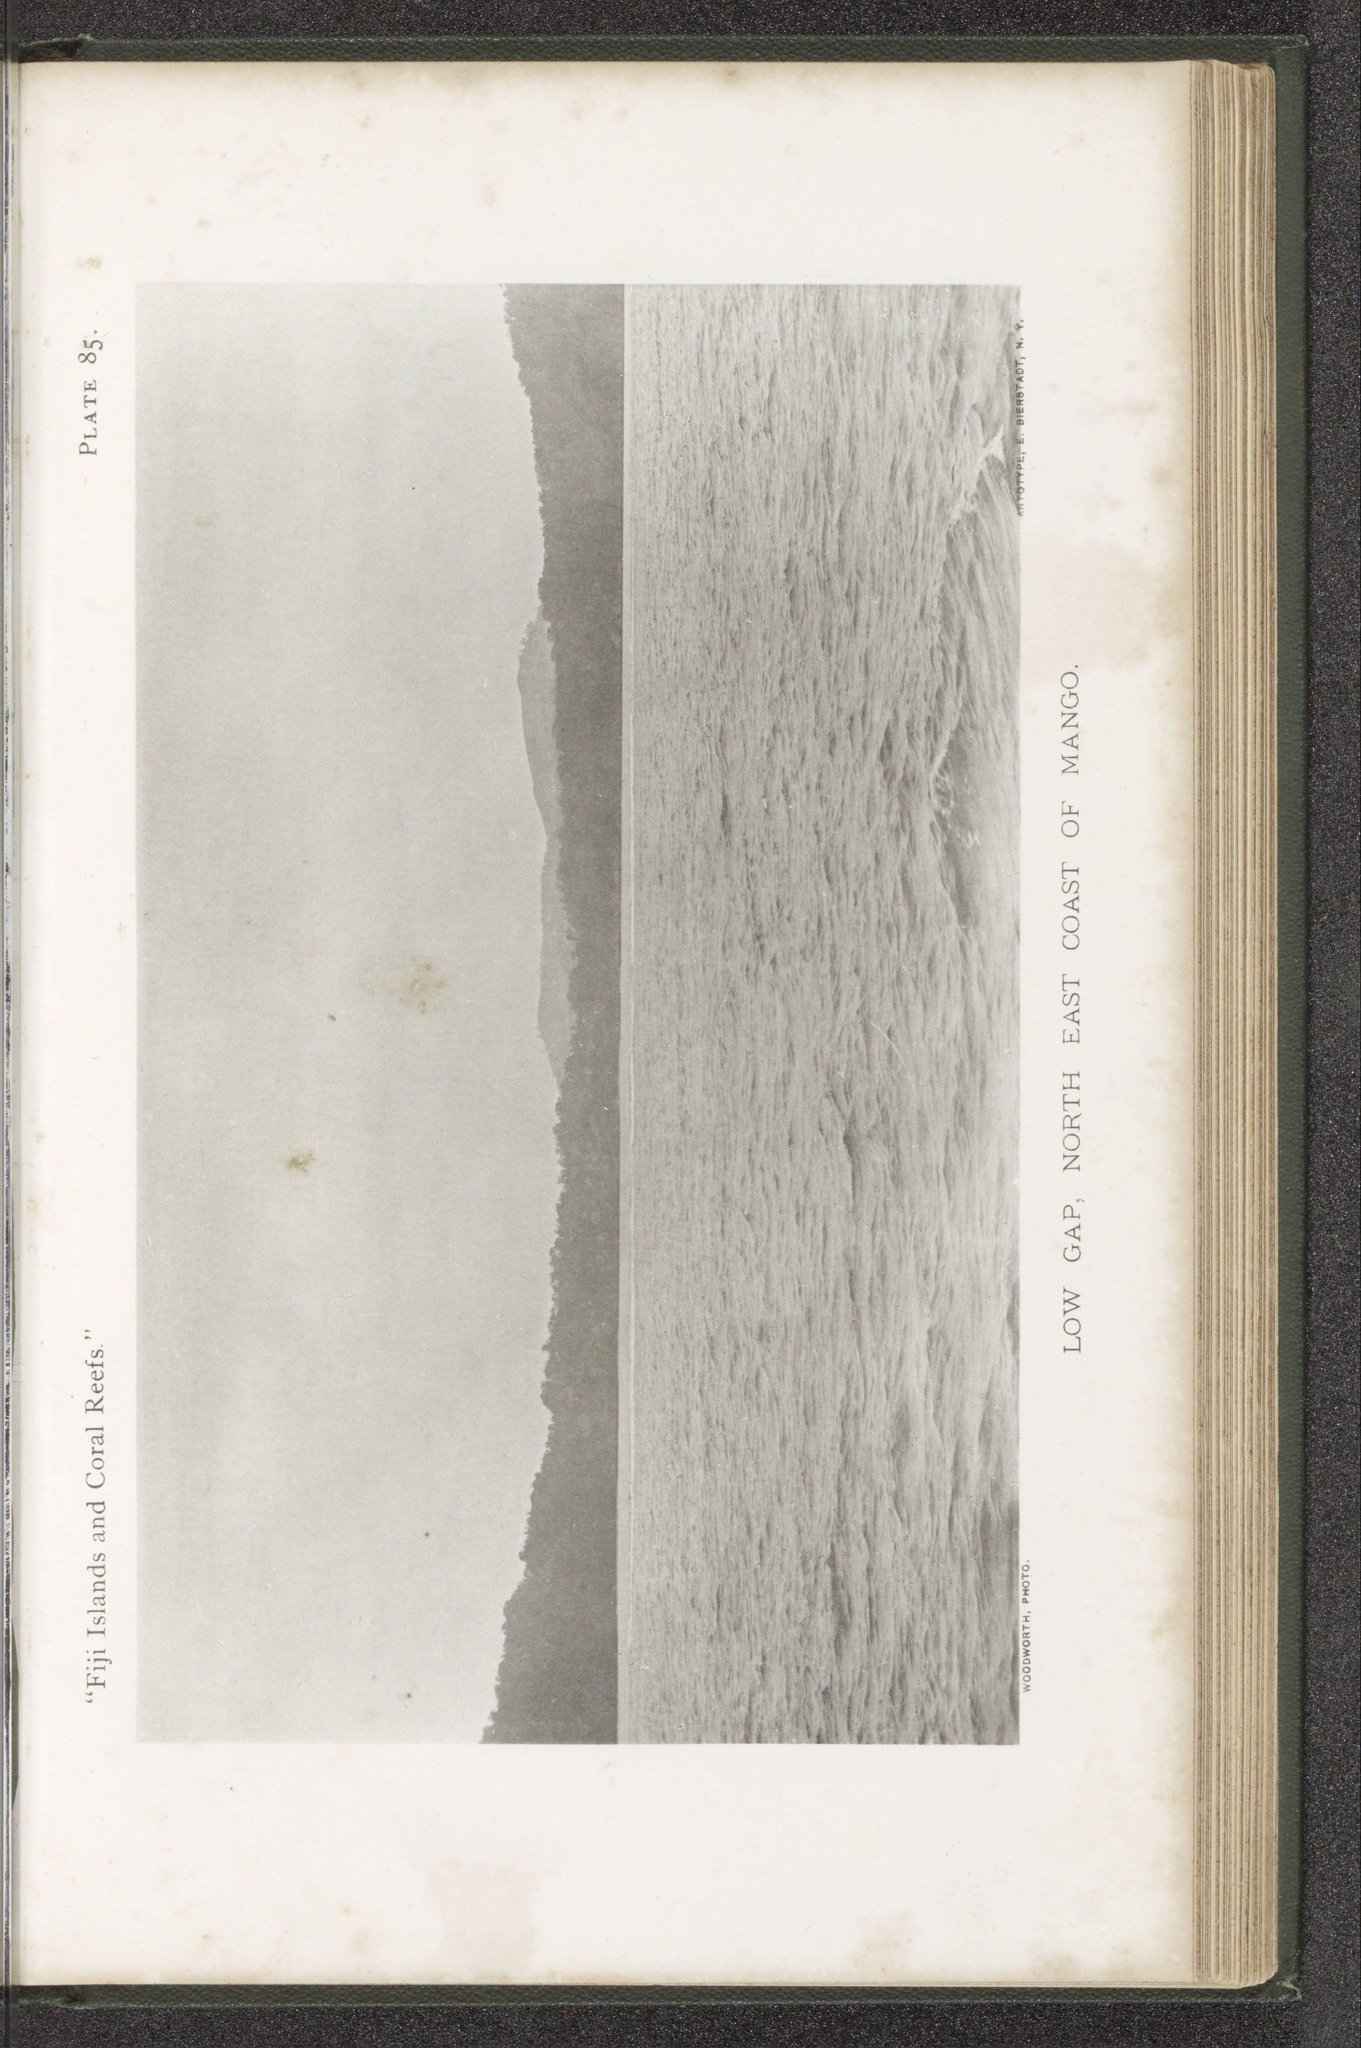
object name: page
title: Low gap, north east coast of Mango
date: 1885-1899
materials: paper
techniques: photograph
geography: fiji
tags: island, ocean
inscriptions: name: ‘Artotype, E. Bierstadt, N. Y.’, number: ‘Plate 85.’, name: ‘Woodworth, Photo.’